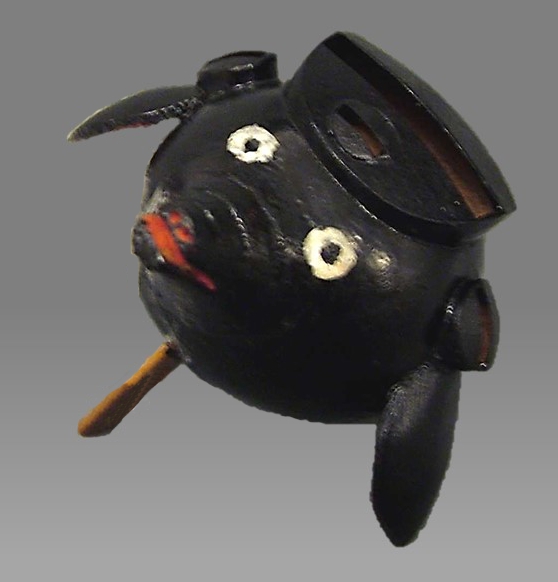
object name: ko tze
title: Ko-Tze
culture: chinese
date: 1867-1900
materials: wood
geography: china